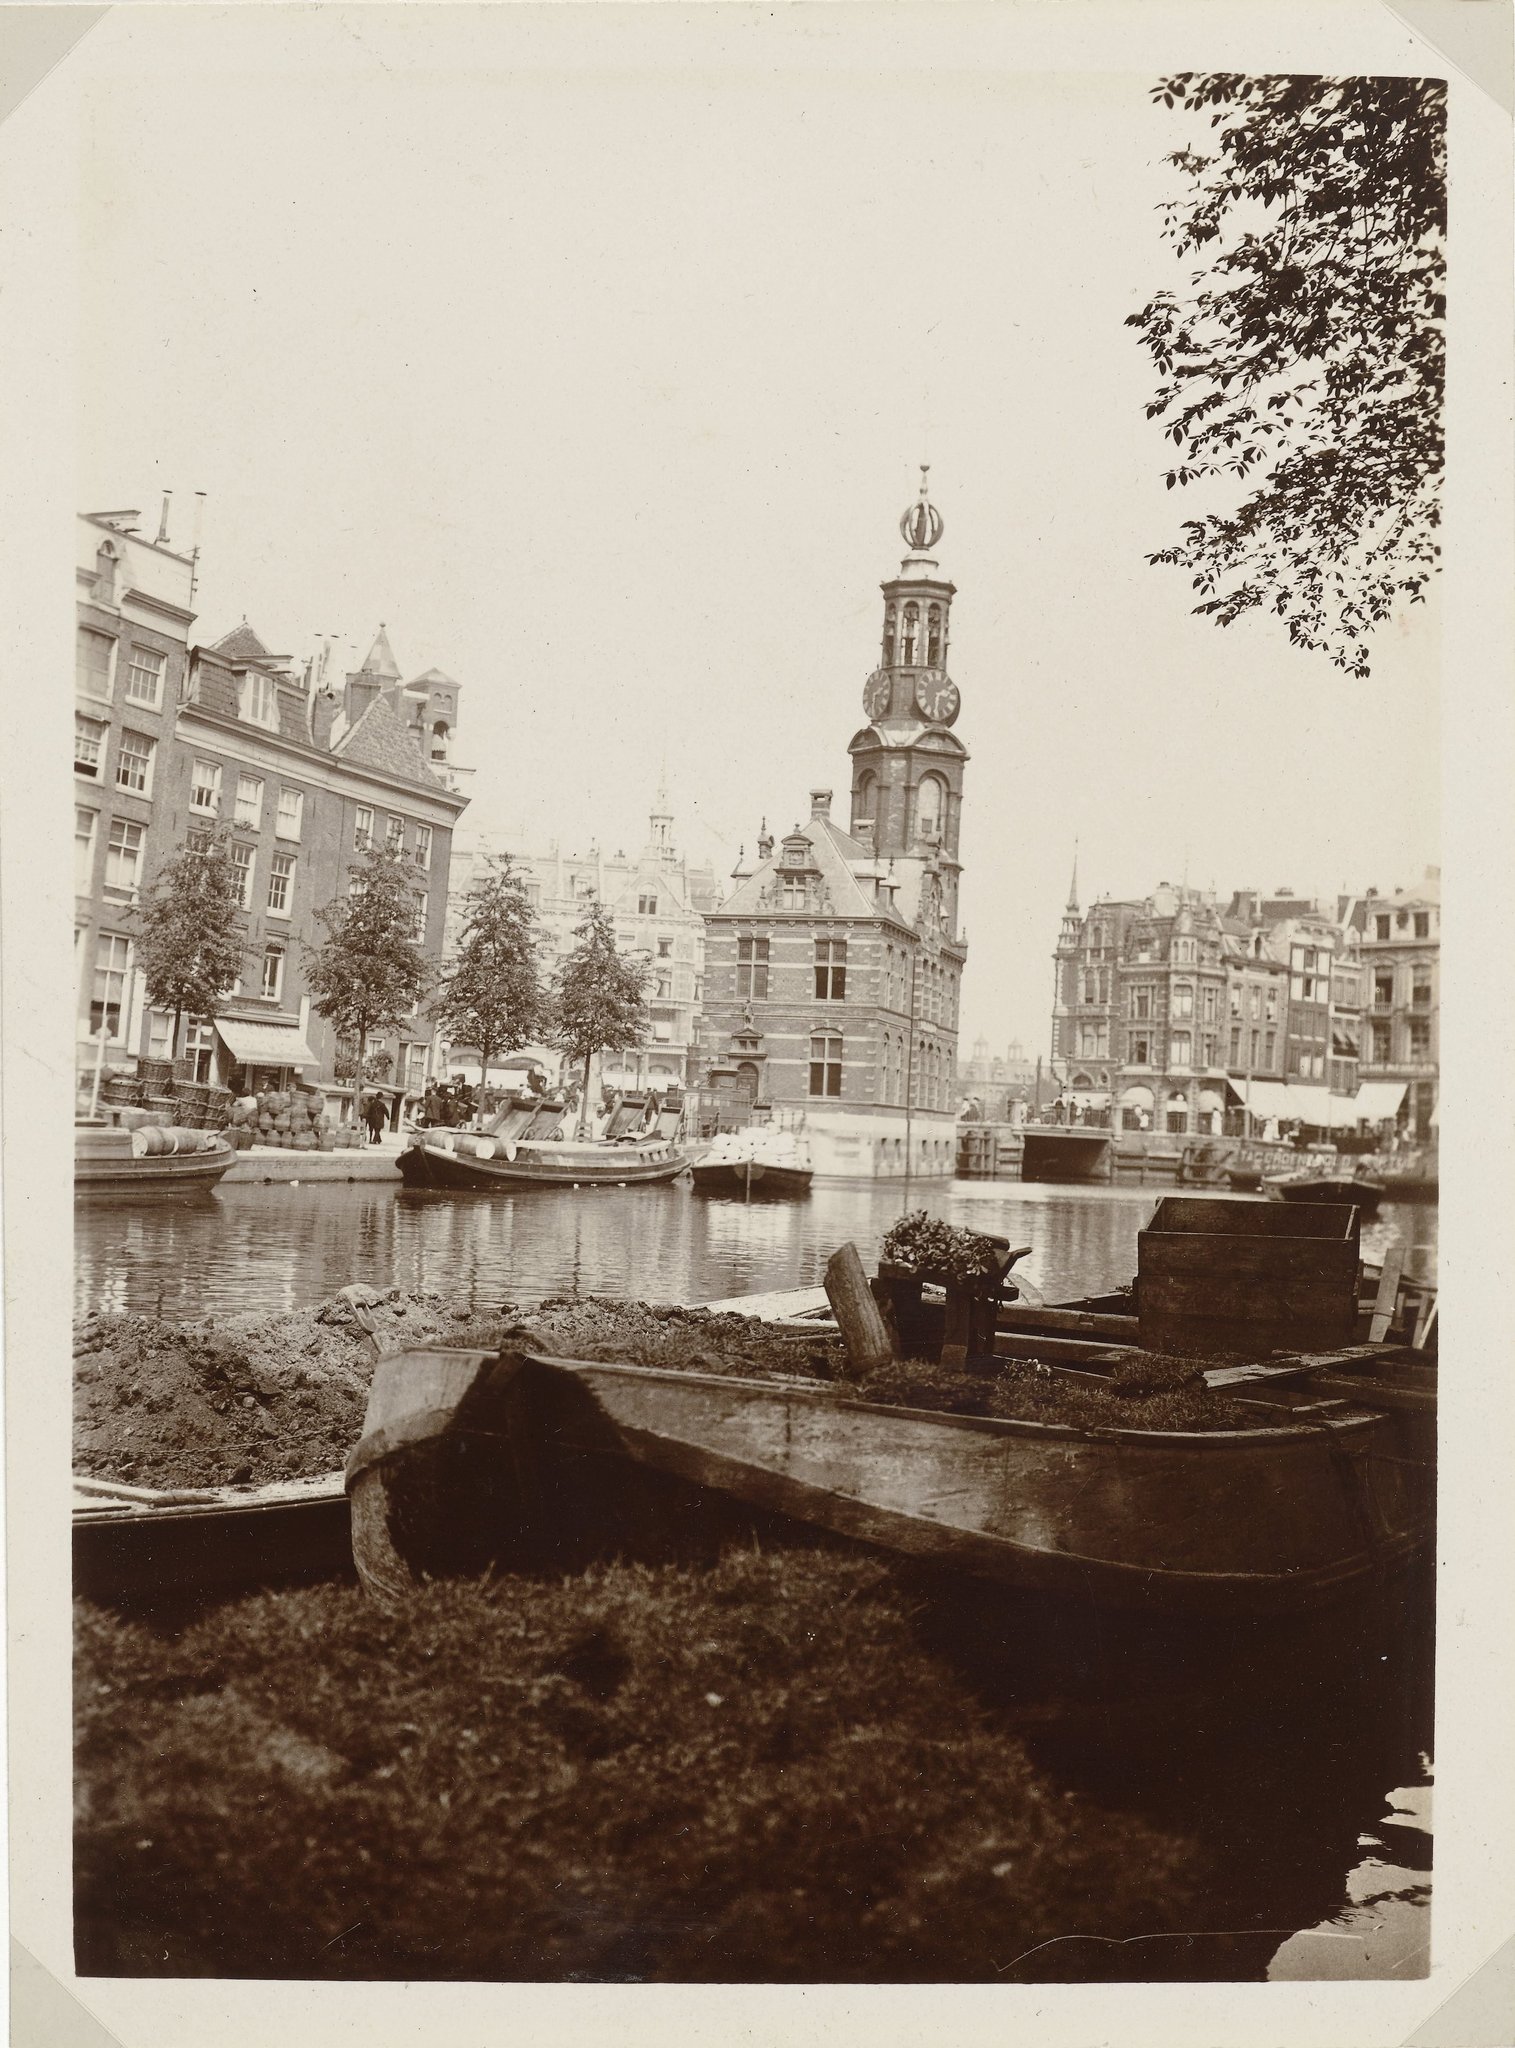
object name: photograph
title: Munttoren, gezien vanaf de Bloemenmarkt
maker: james higson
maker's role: politician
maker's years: 1862-1933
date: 1904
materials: paper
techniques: gelatin silver print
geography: amsterdam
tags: tower, clock tower ~ monumental adornment, canals, waters (in city)